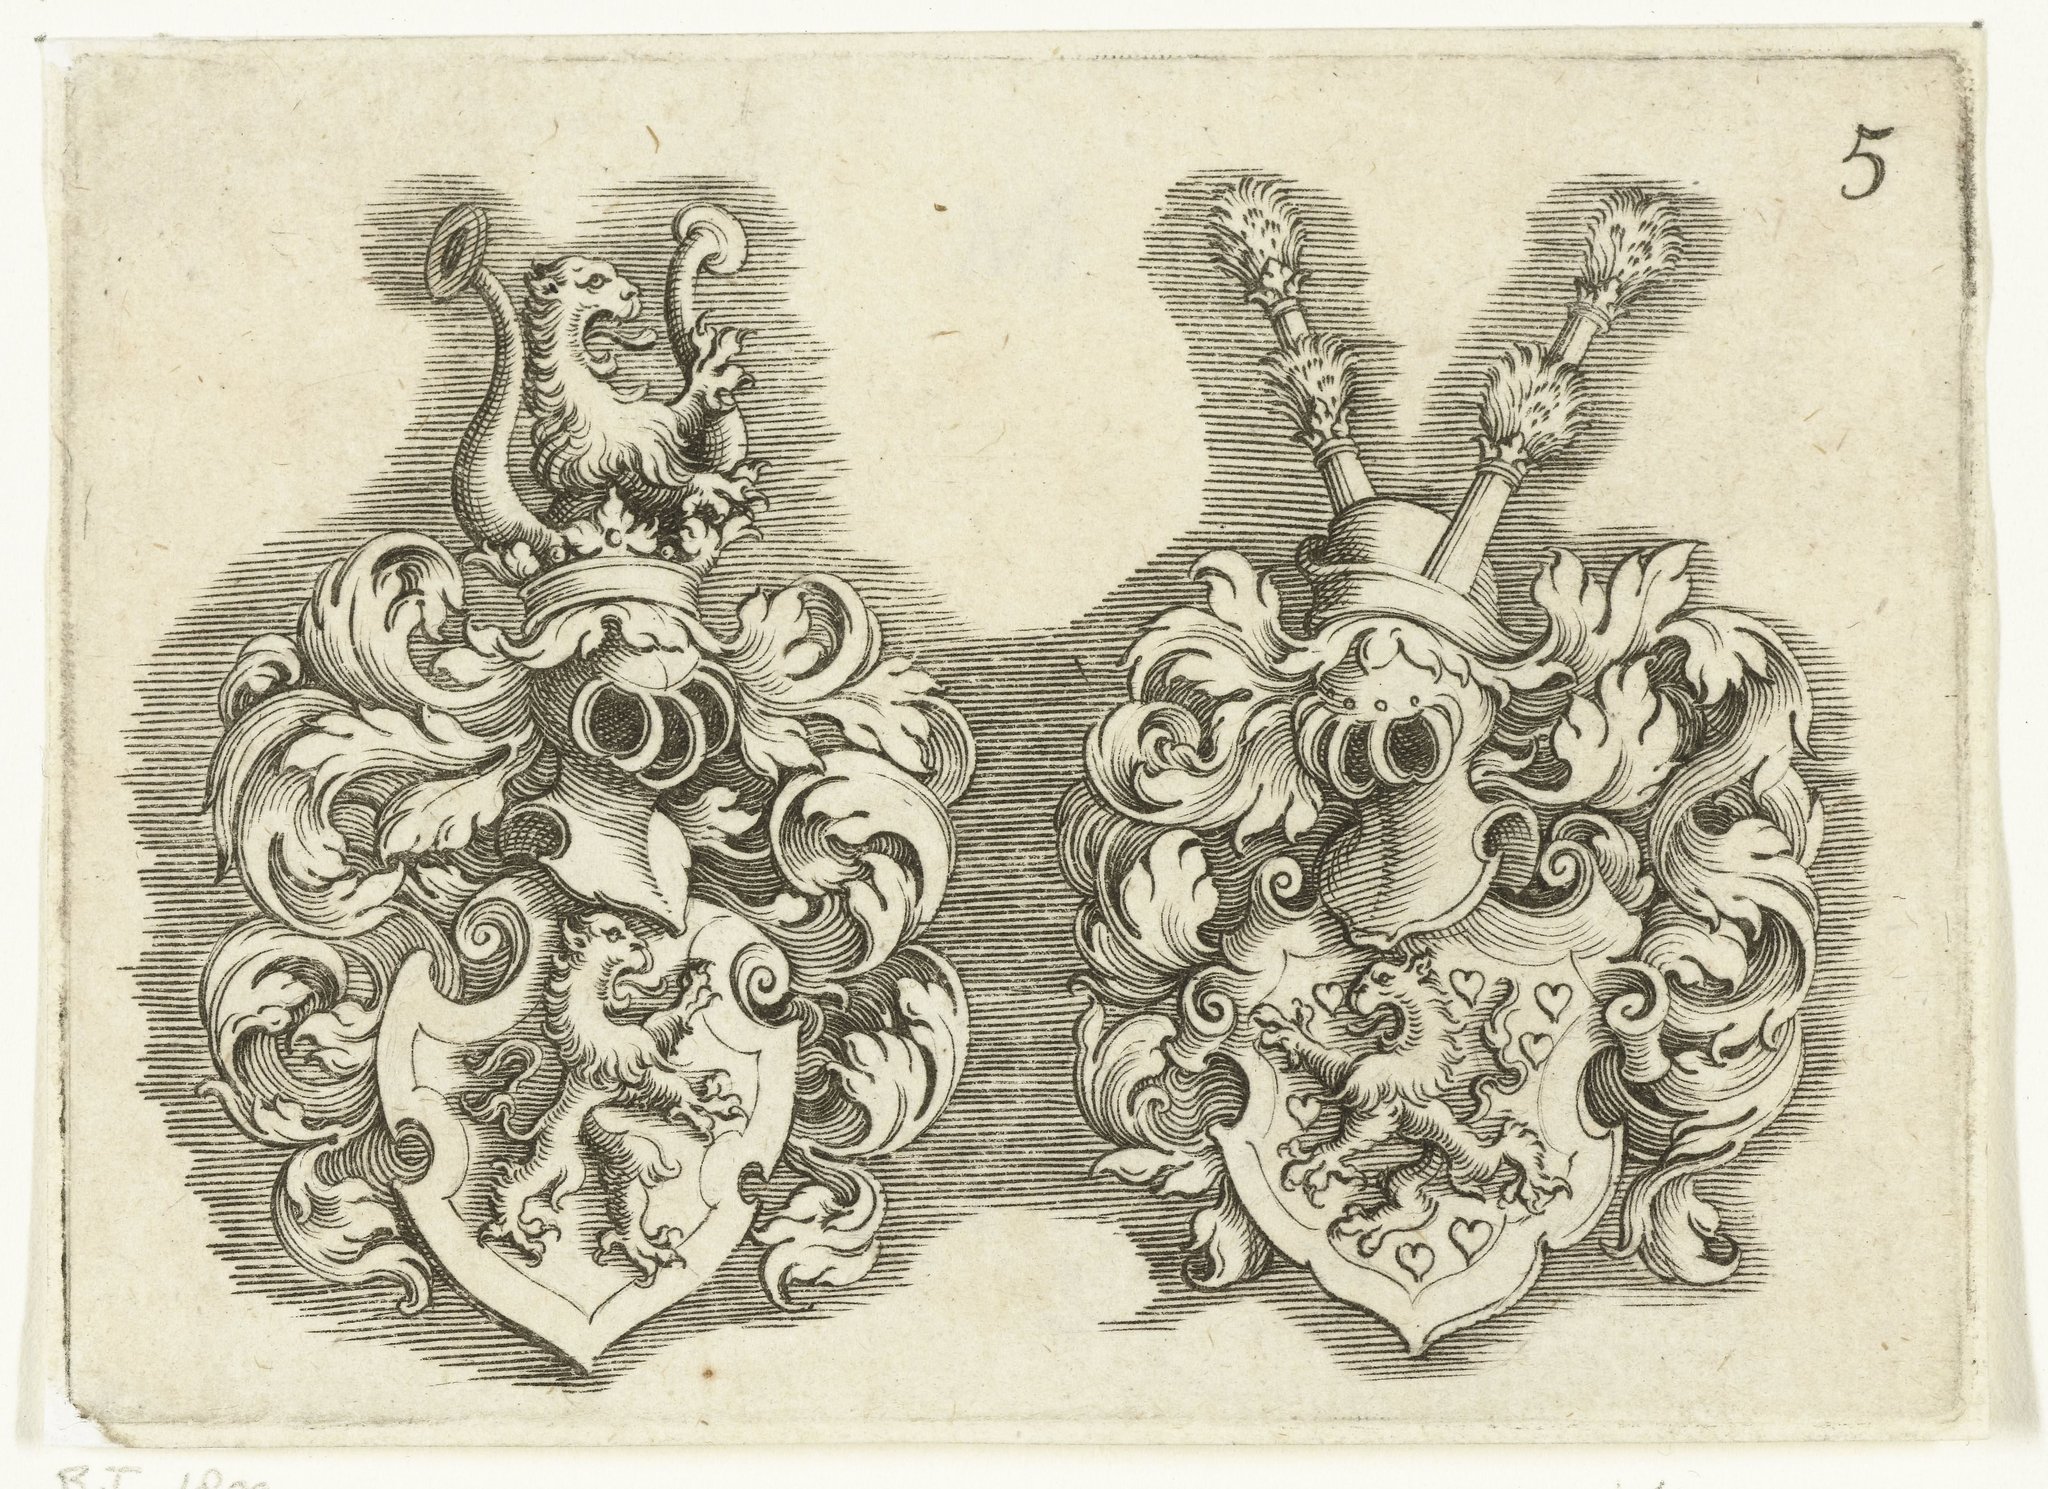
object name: ornament print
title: Twee wapenschilden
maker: Anonymous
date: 1611-1625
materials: paper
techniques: engraving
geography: amsterdam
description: Links de 'duché de Juliers', rechts de 'comté d'Orlamünde'.